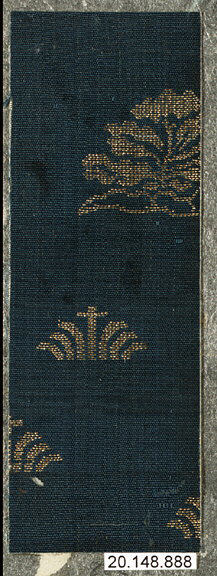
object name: piece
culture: chinese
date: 1701-1800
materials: silk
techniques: compound weave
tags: leaves